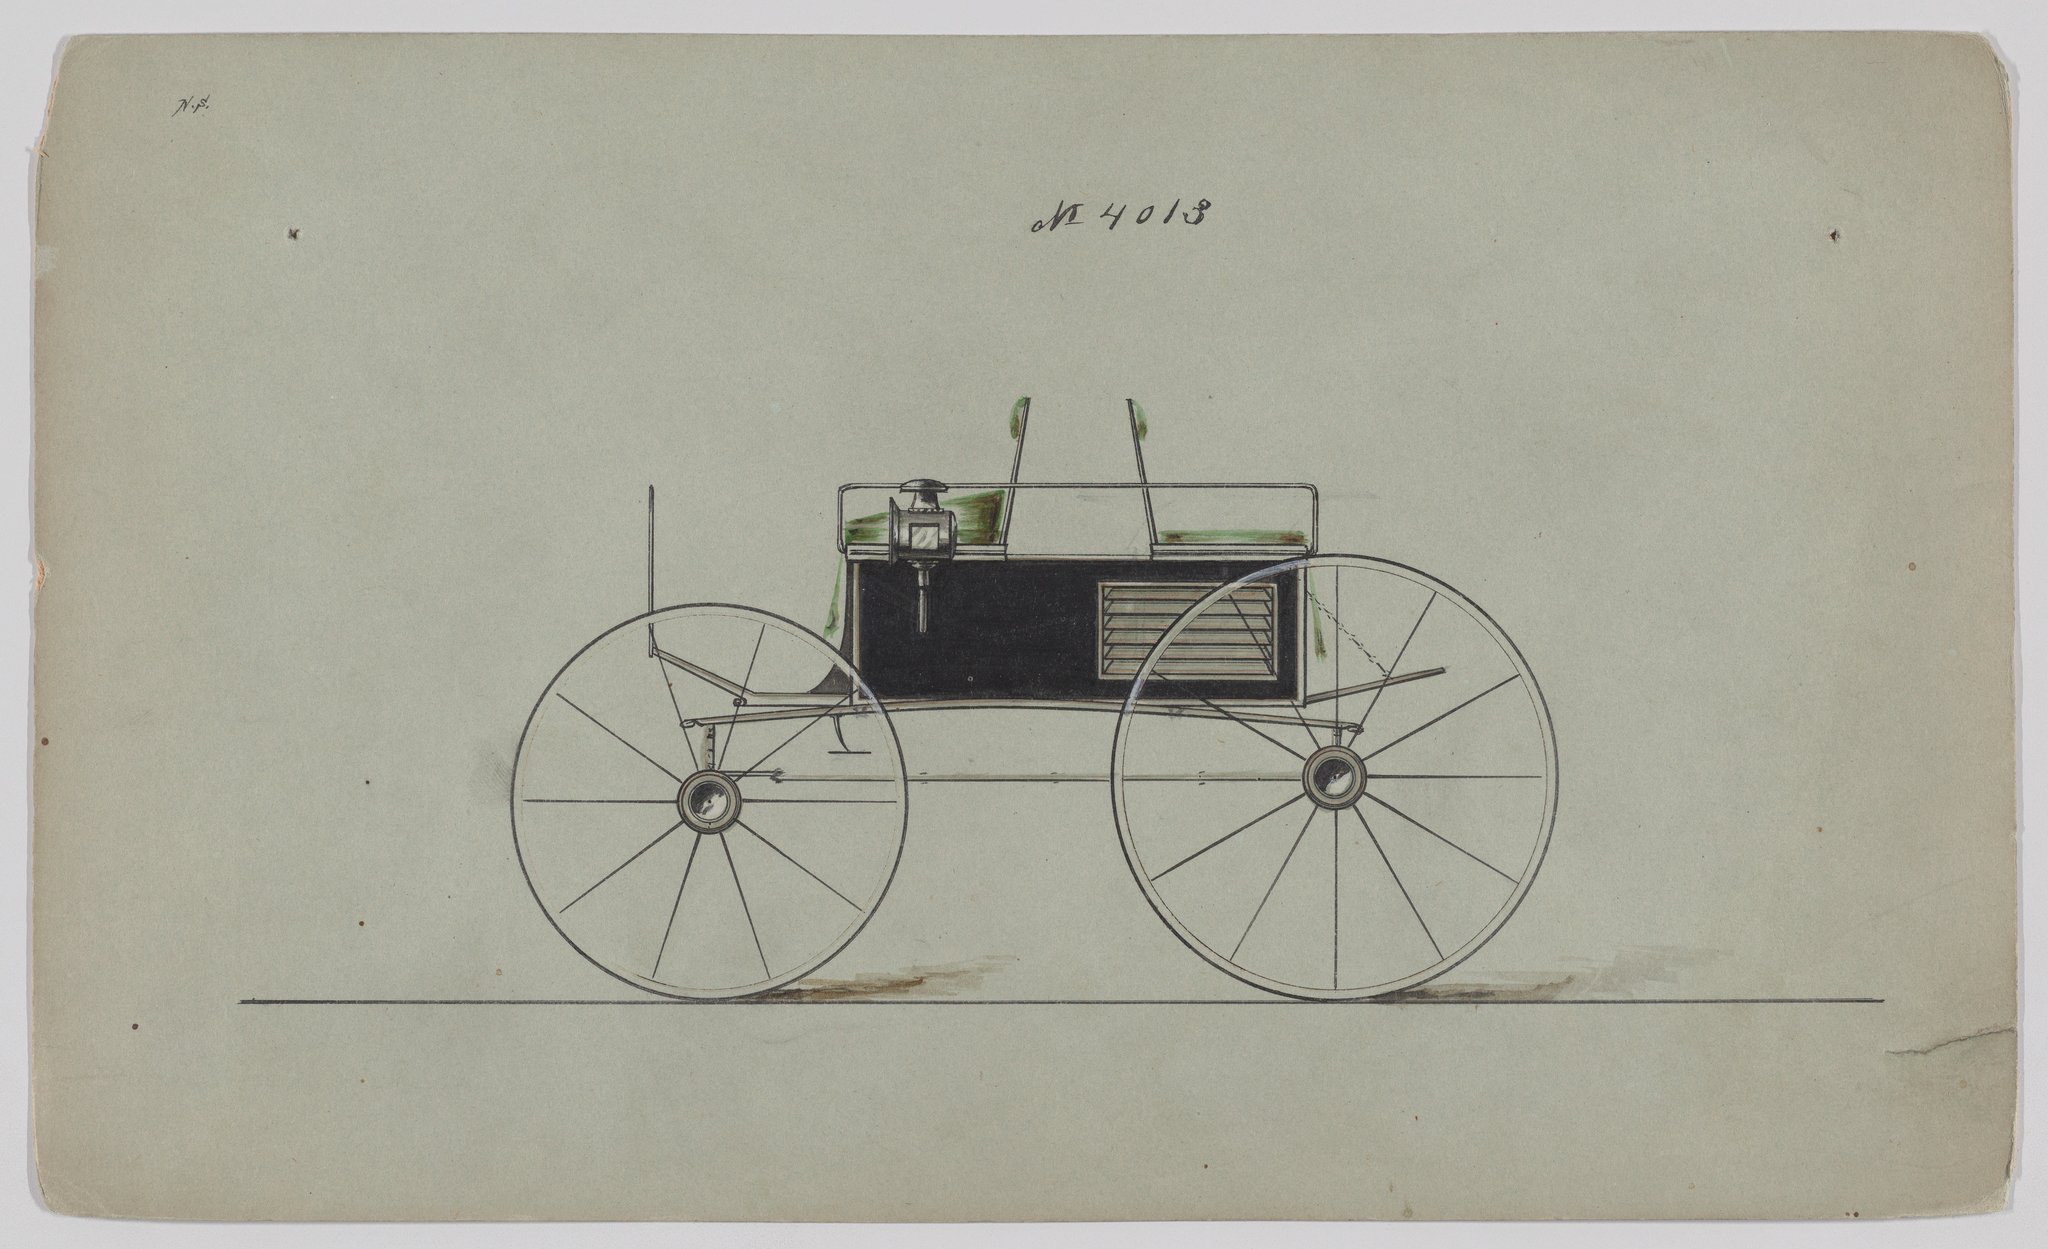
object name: drawing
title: Design for Dog Cart or 2 Wheeler, no. 4013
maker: brewster & co.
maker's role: manufacturer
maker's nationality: american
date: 1888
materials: gouache, gum arabic, ink, watercolor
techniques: pen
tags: carriages